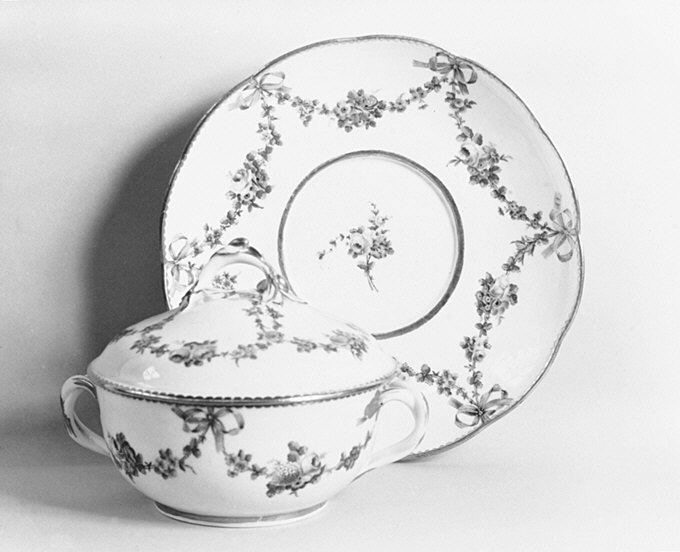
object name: bowl with cover and tray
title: Bowl with cover (écuelle) and tray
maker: sèvres manufactory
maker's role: manufactory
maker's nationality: french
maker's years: 1740-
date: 1766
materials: soft paste porcelain